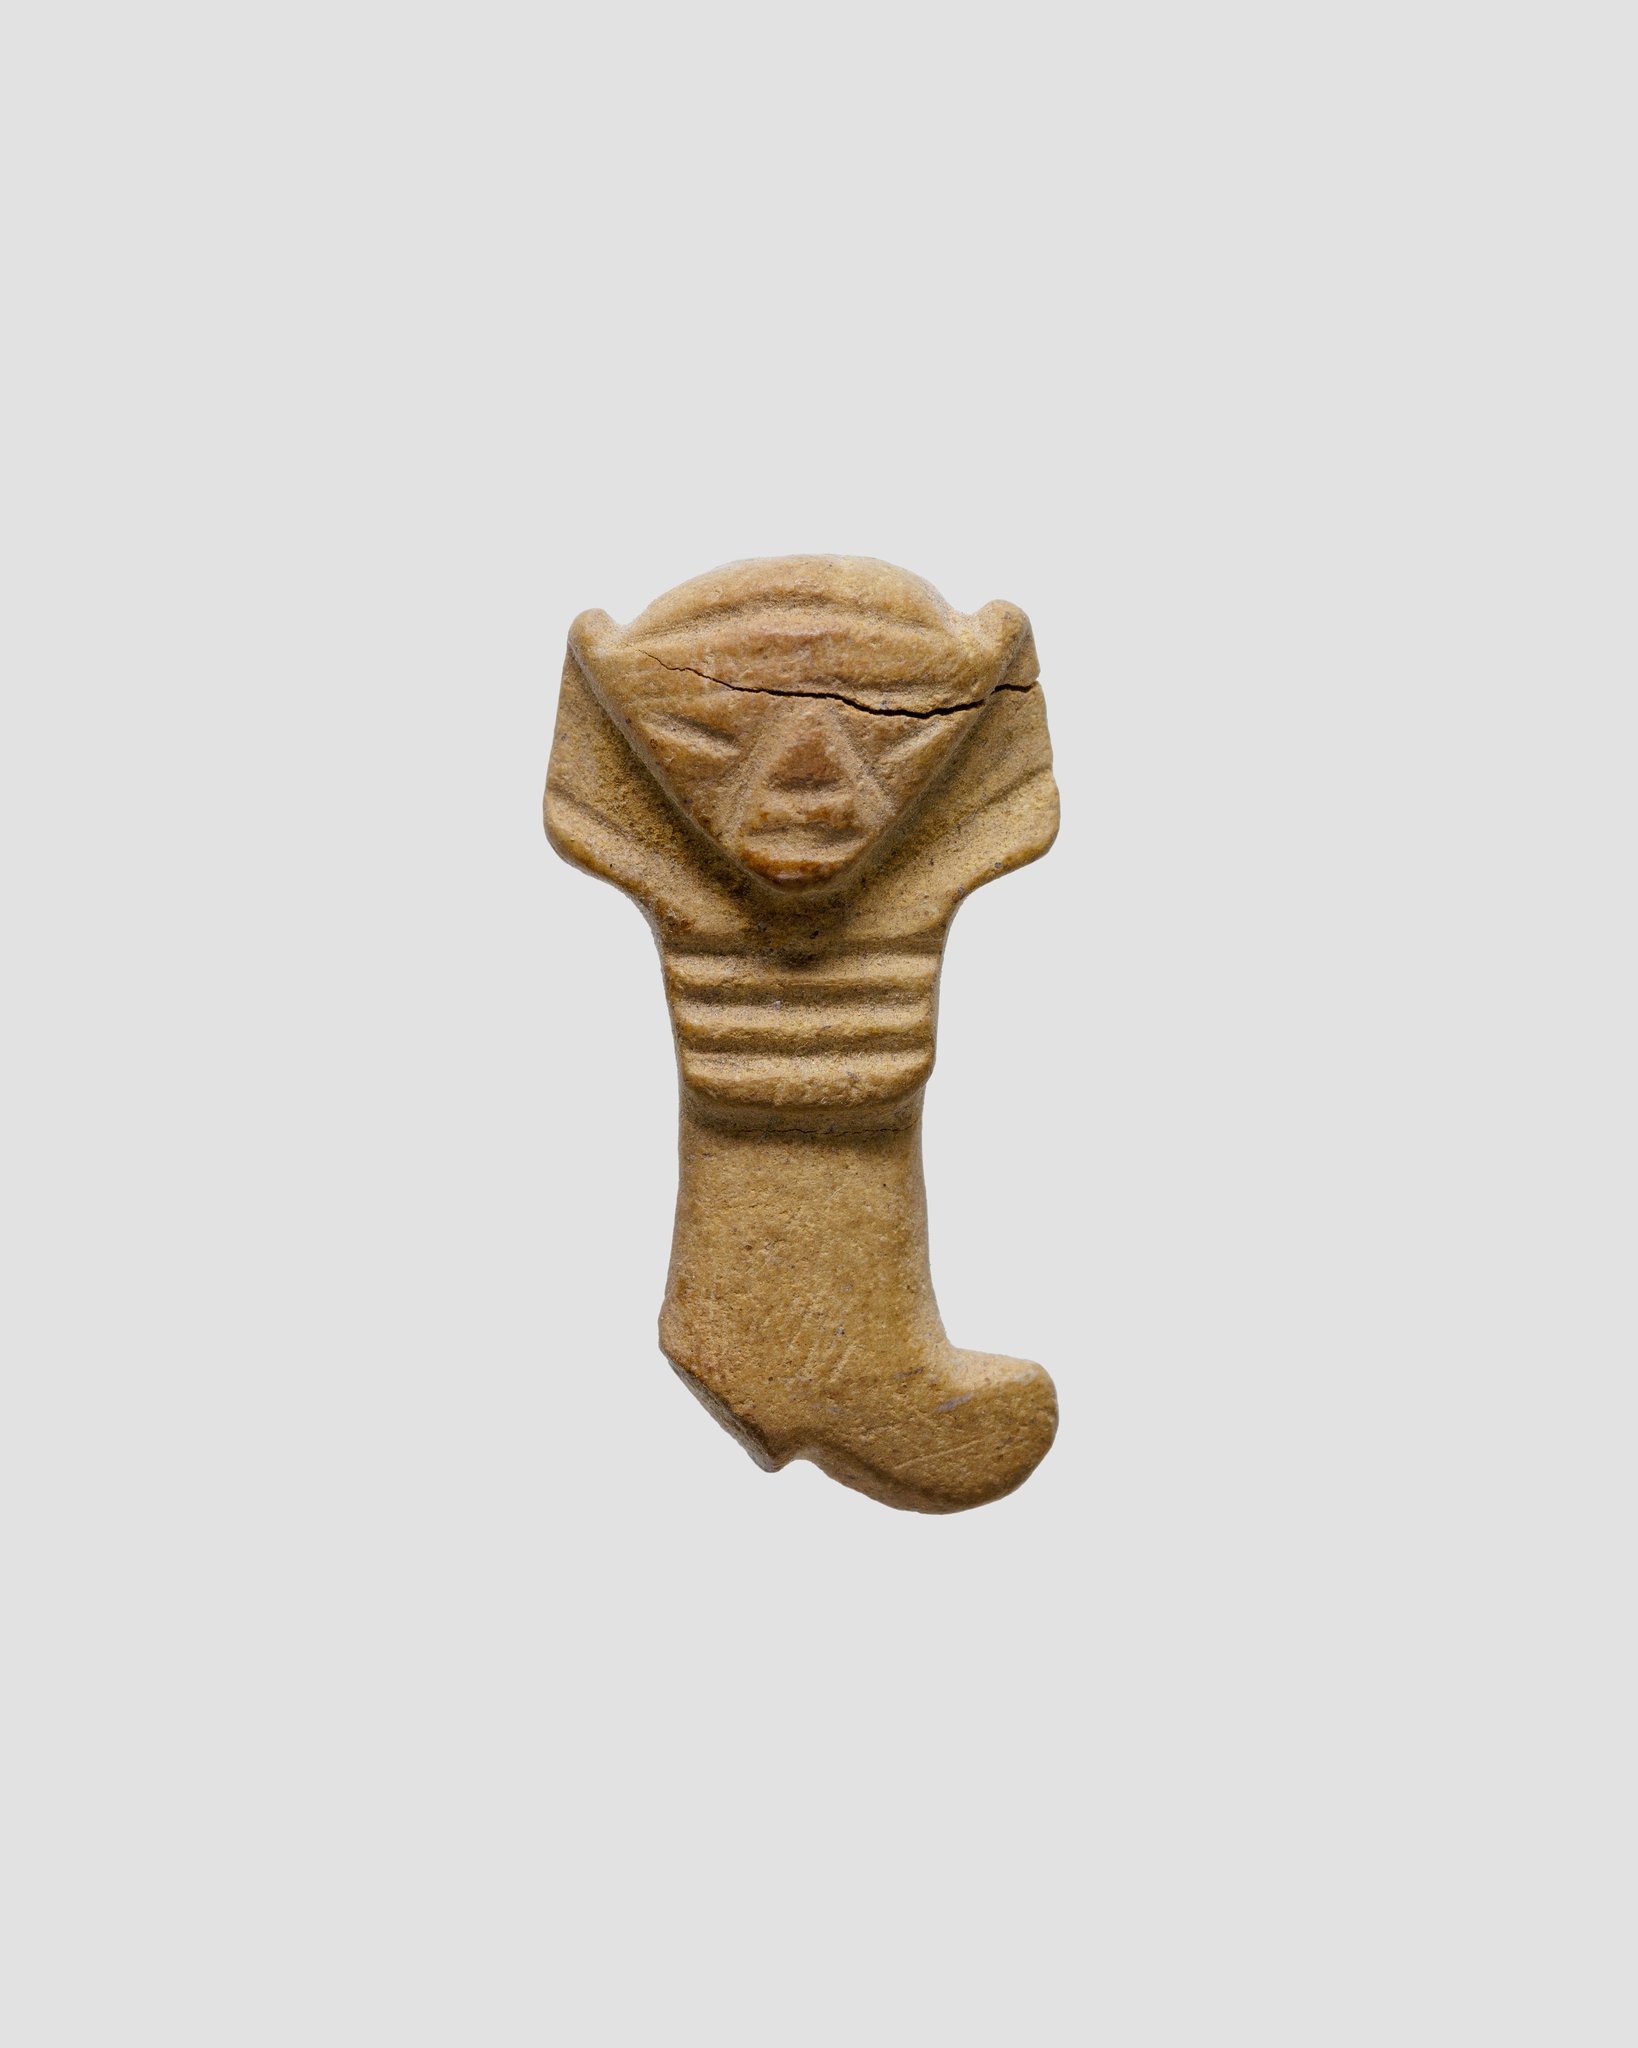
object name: amulet, opening of the mouth peseshkef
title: "Opening of the Mouth", Peseshkef tool amulet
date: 2150-1950 BCE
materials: bone, ivory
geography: egypt